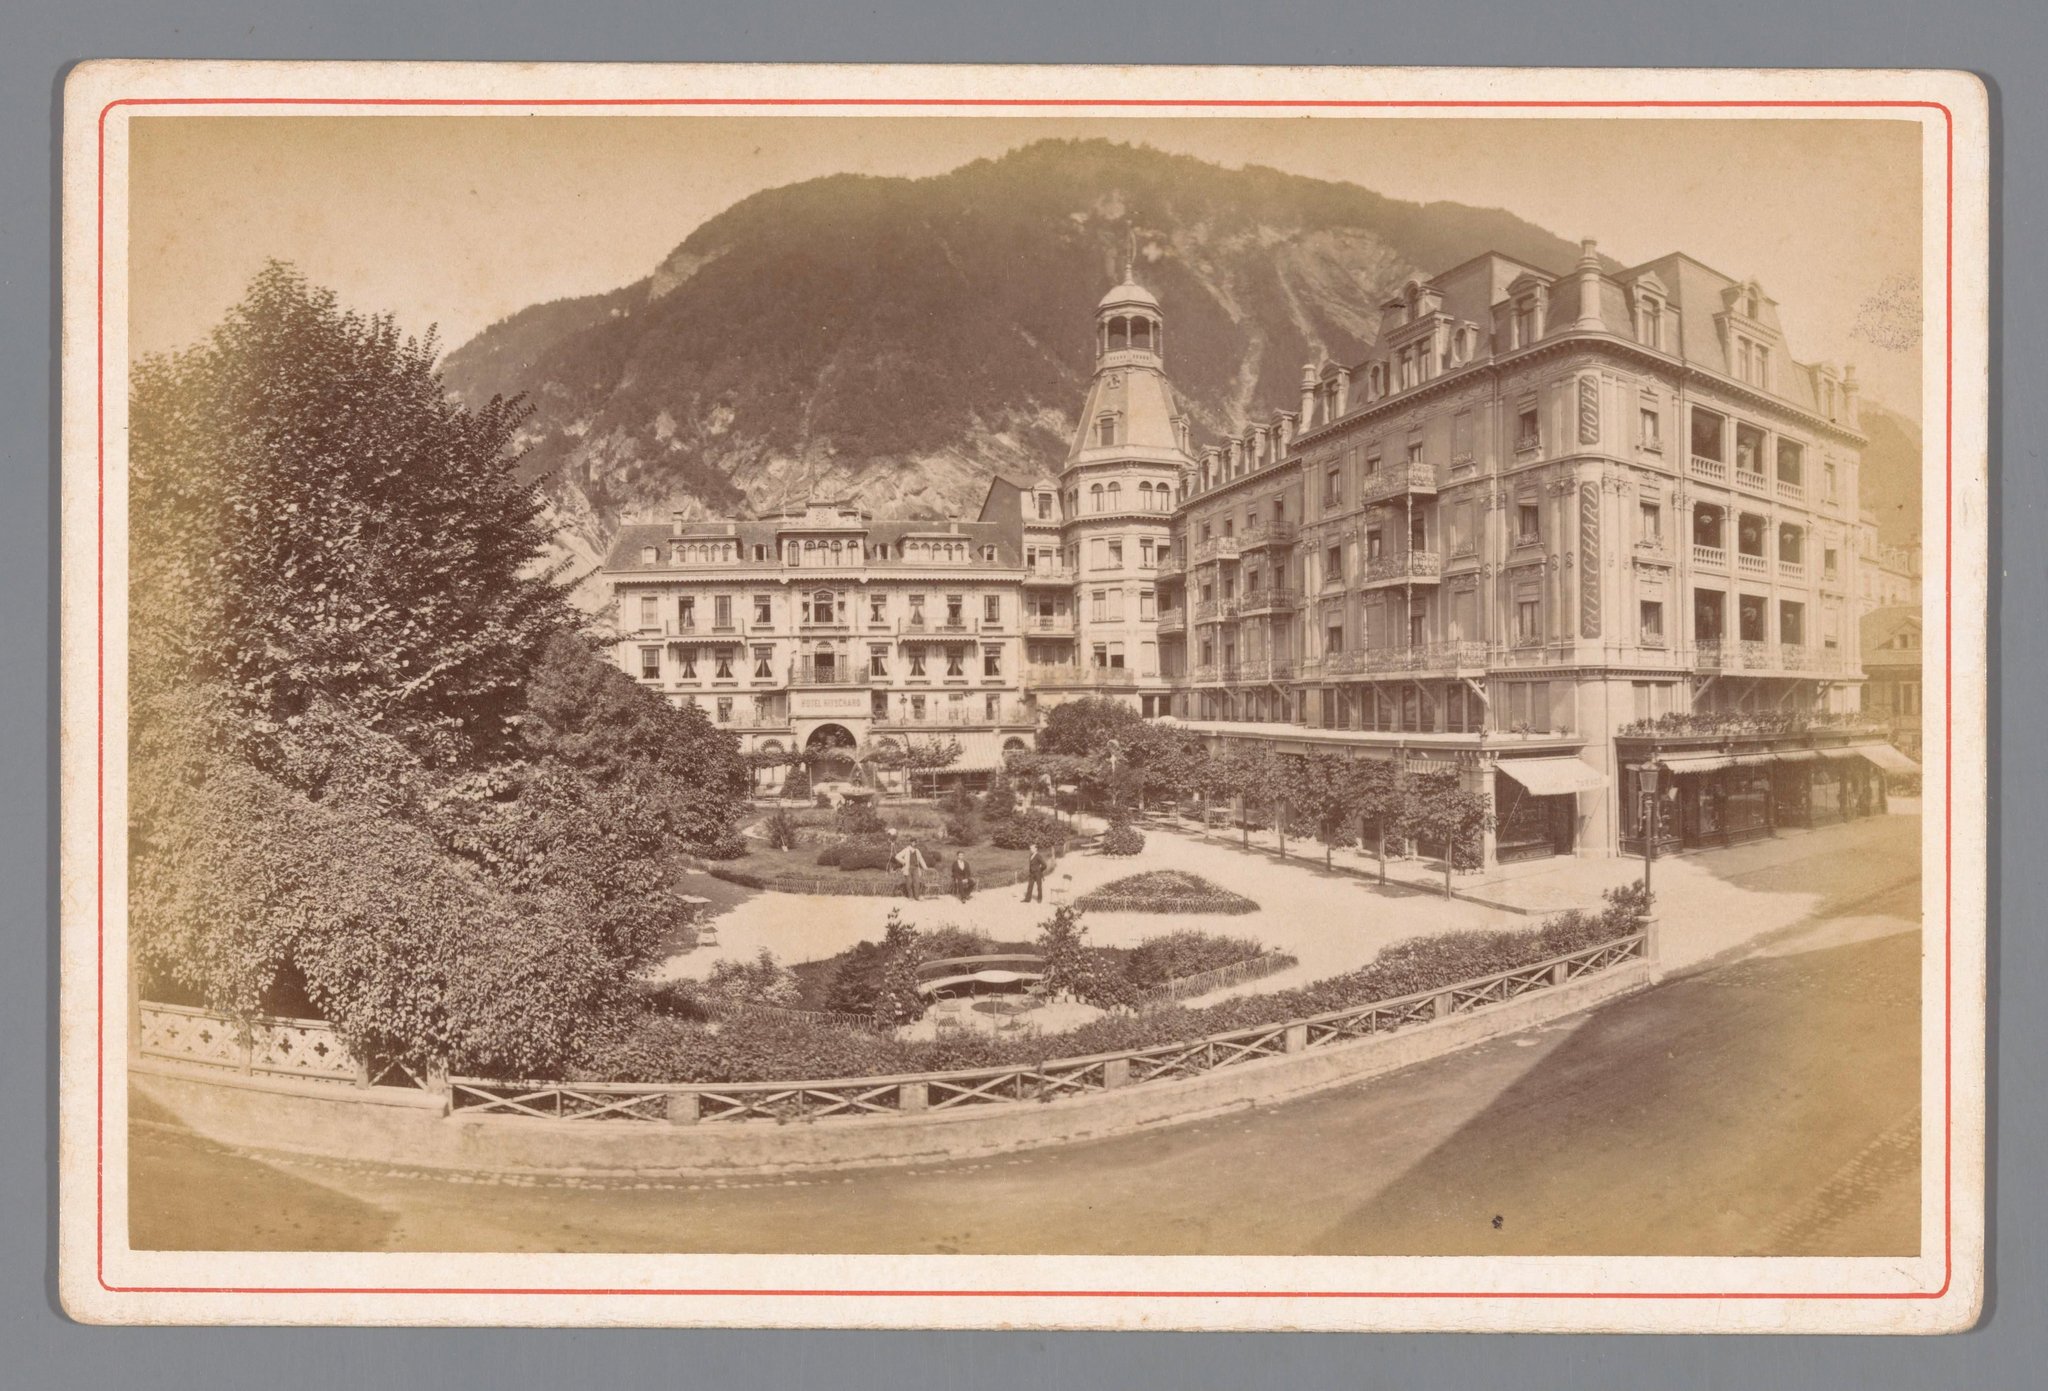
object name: cabinet photograph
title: Interlaken. Hôtel Ritschard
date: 1860-1877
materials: cardboard, photographic support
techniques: albumen print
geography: interlaken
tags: hotel, hostelry, inn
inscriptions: number: ‘1440’